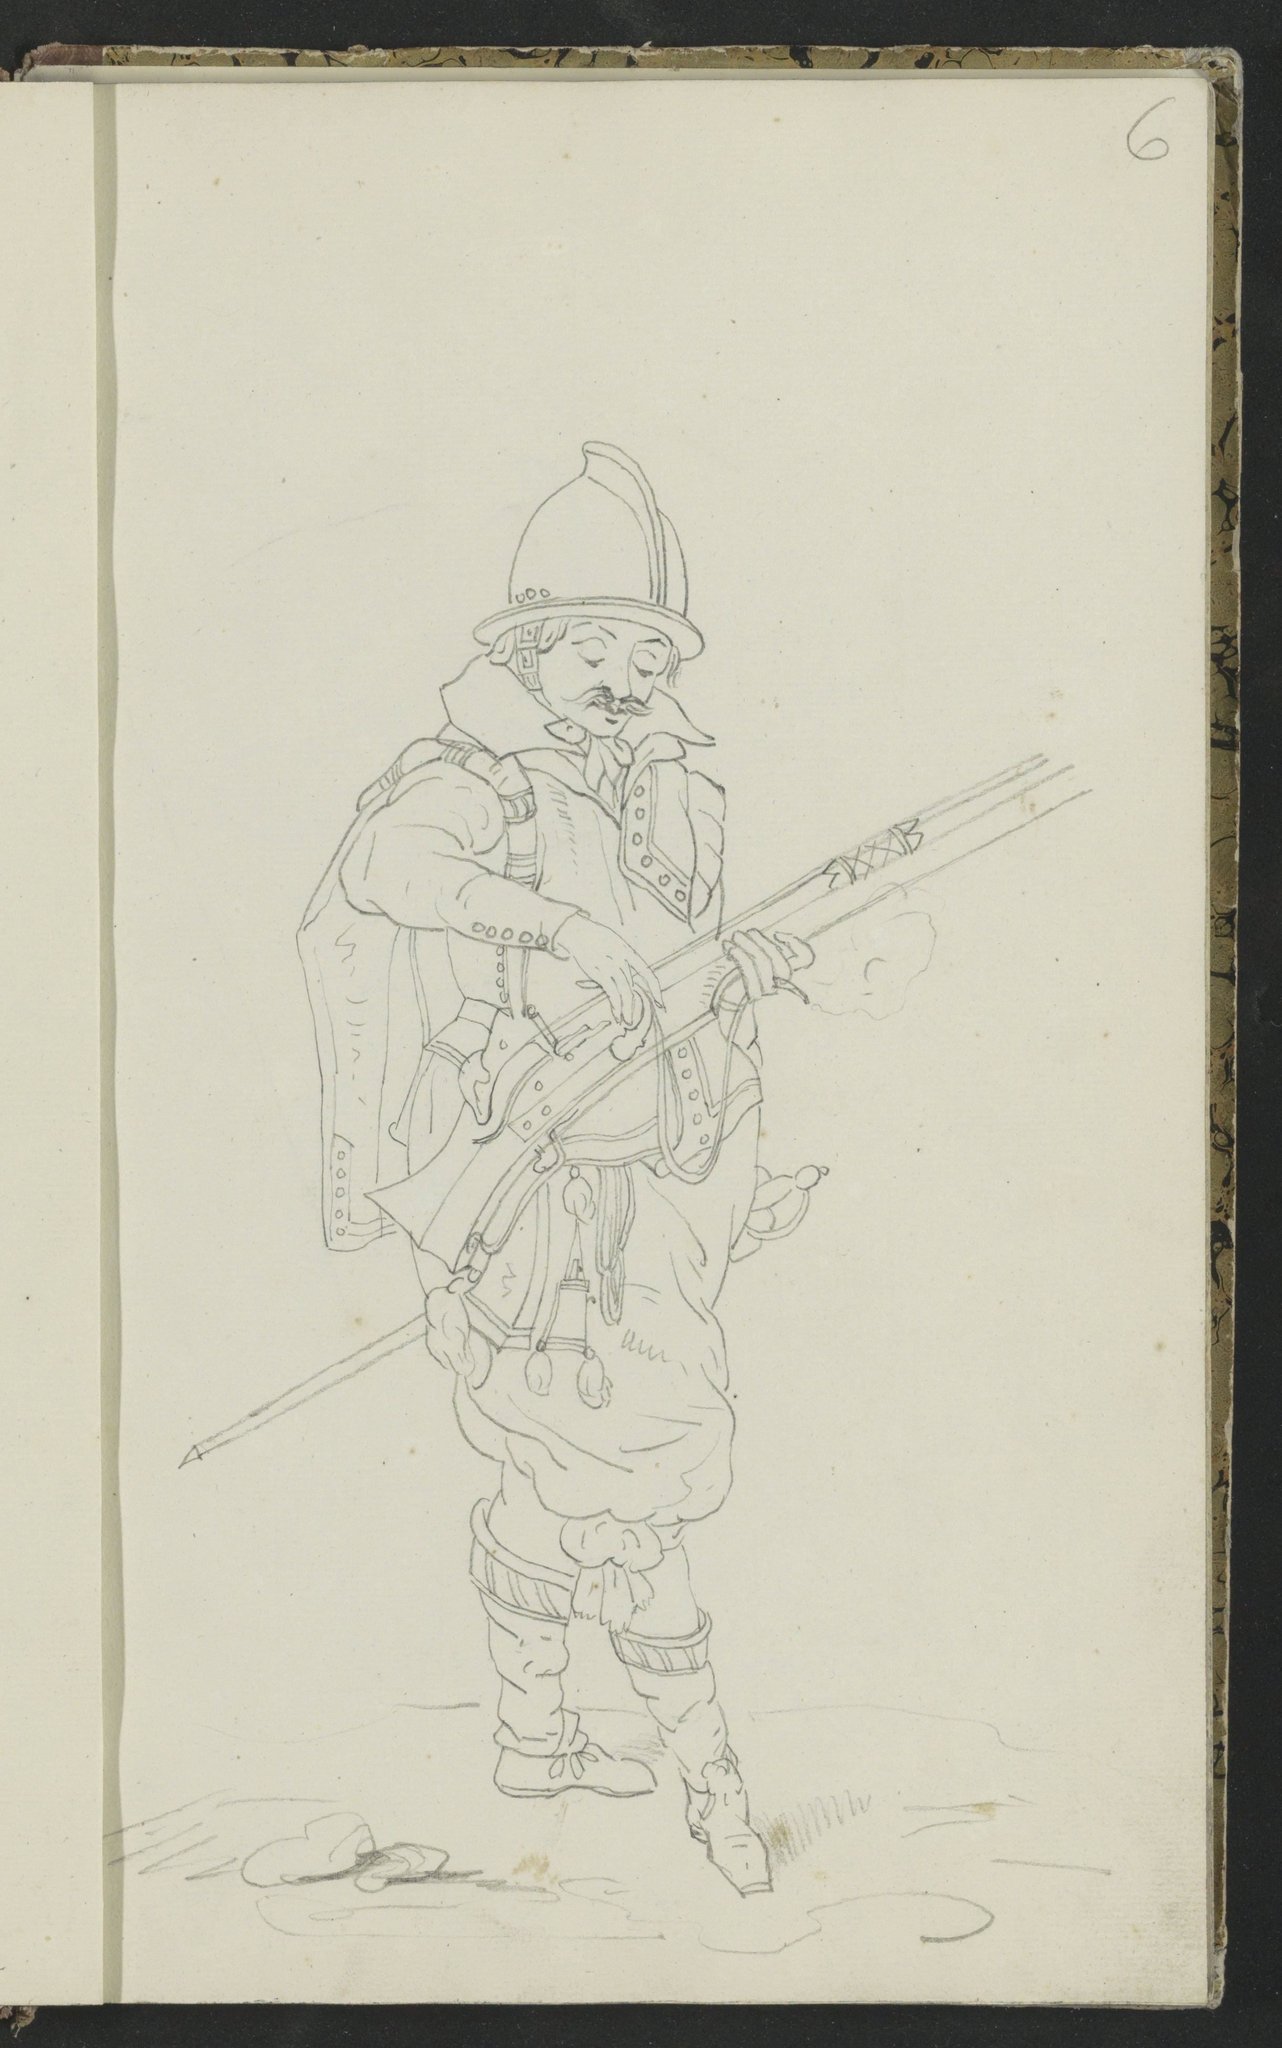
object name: sketchbook leaf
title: Soldaat die de pan van zijn musket sluit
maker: johannes antonius canta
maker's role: draughtsman, painter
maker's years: 1816-1888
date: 1826-1888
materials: paper, pencil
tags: firearms, (military) uniforms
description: Kopie naar Jacob de Gheyns 'Wapenhandelinghe van roers musquetten ende spiessen: achtervolghende de ordre van syn excellentie Maurits prince van Orangie grave van Nassau &c' uit 1607. Blad 6 recto uit een schetsboek en album met 59 bladen.